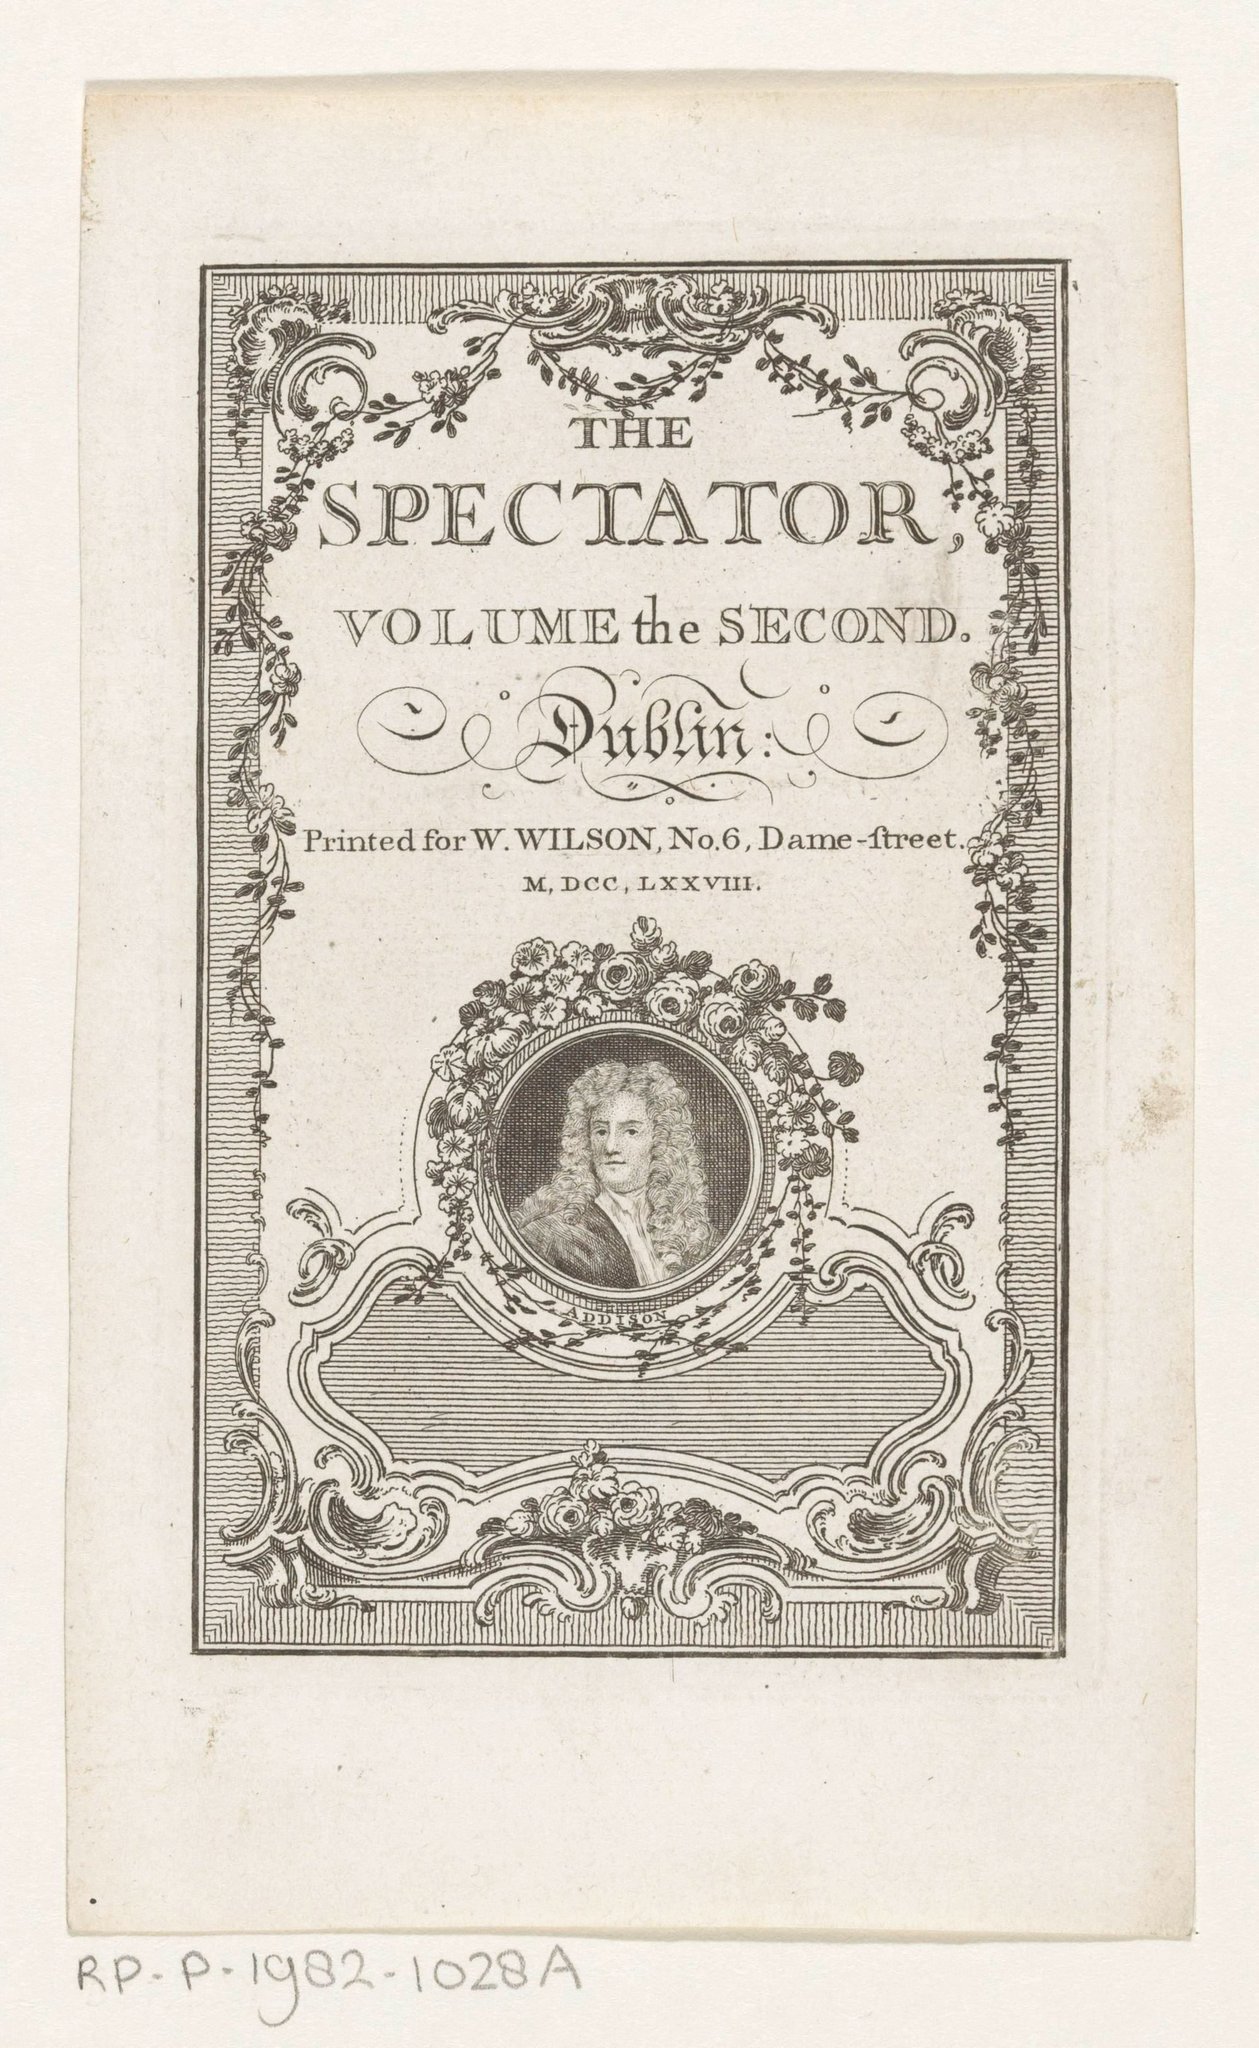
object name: print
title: Portret Joseph Addison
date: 1778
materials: paper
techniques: engraving, etching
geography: dublin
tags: politician, joseph addison, portrait of a writer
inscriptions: collector's mark: Lugt 2760, collector's mark: Lugt 2228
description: Titelpagina voor: S.n. The Spectator, volume the second. Dublin: Wilson, W., 1778.